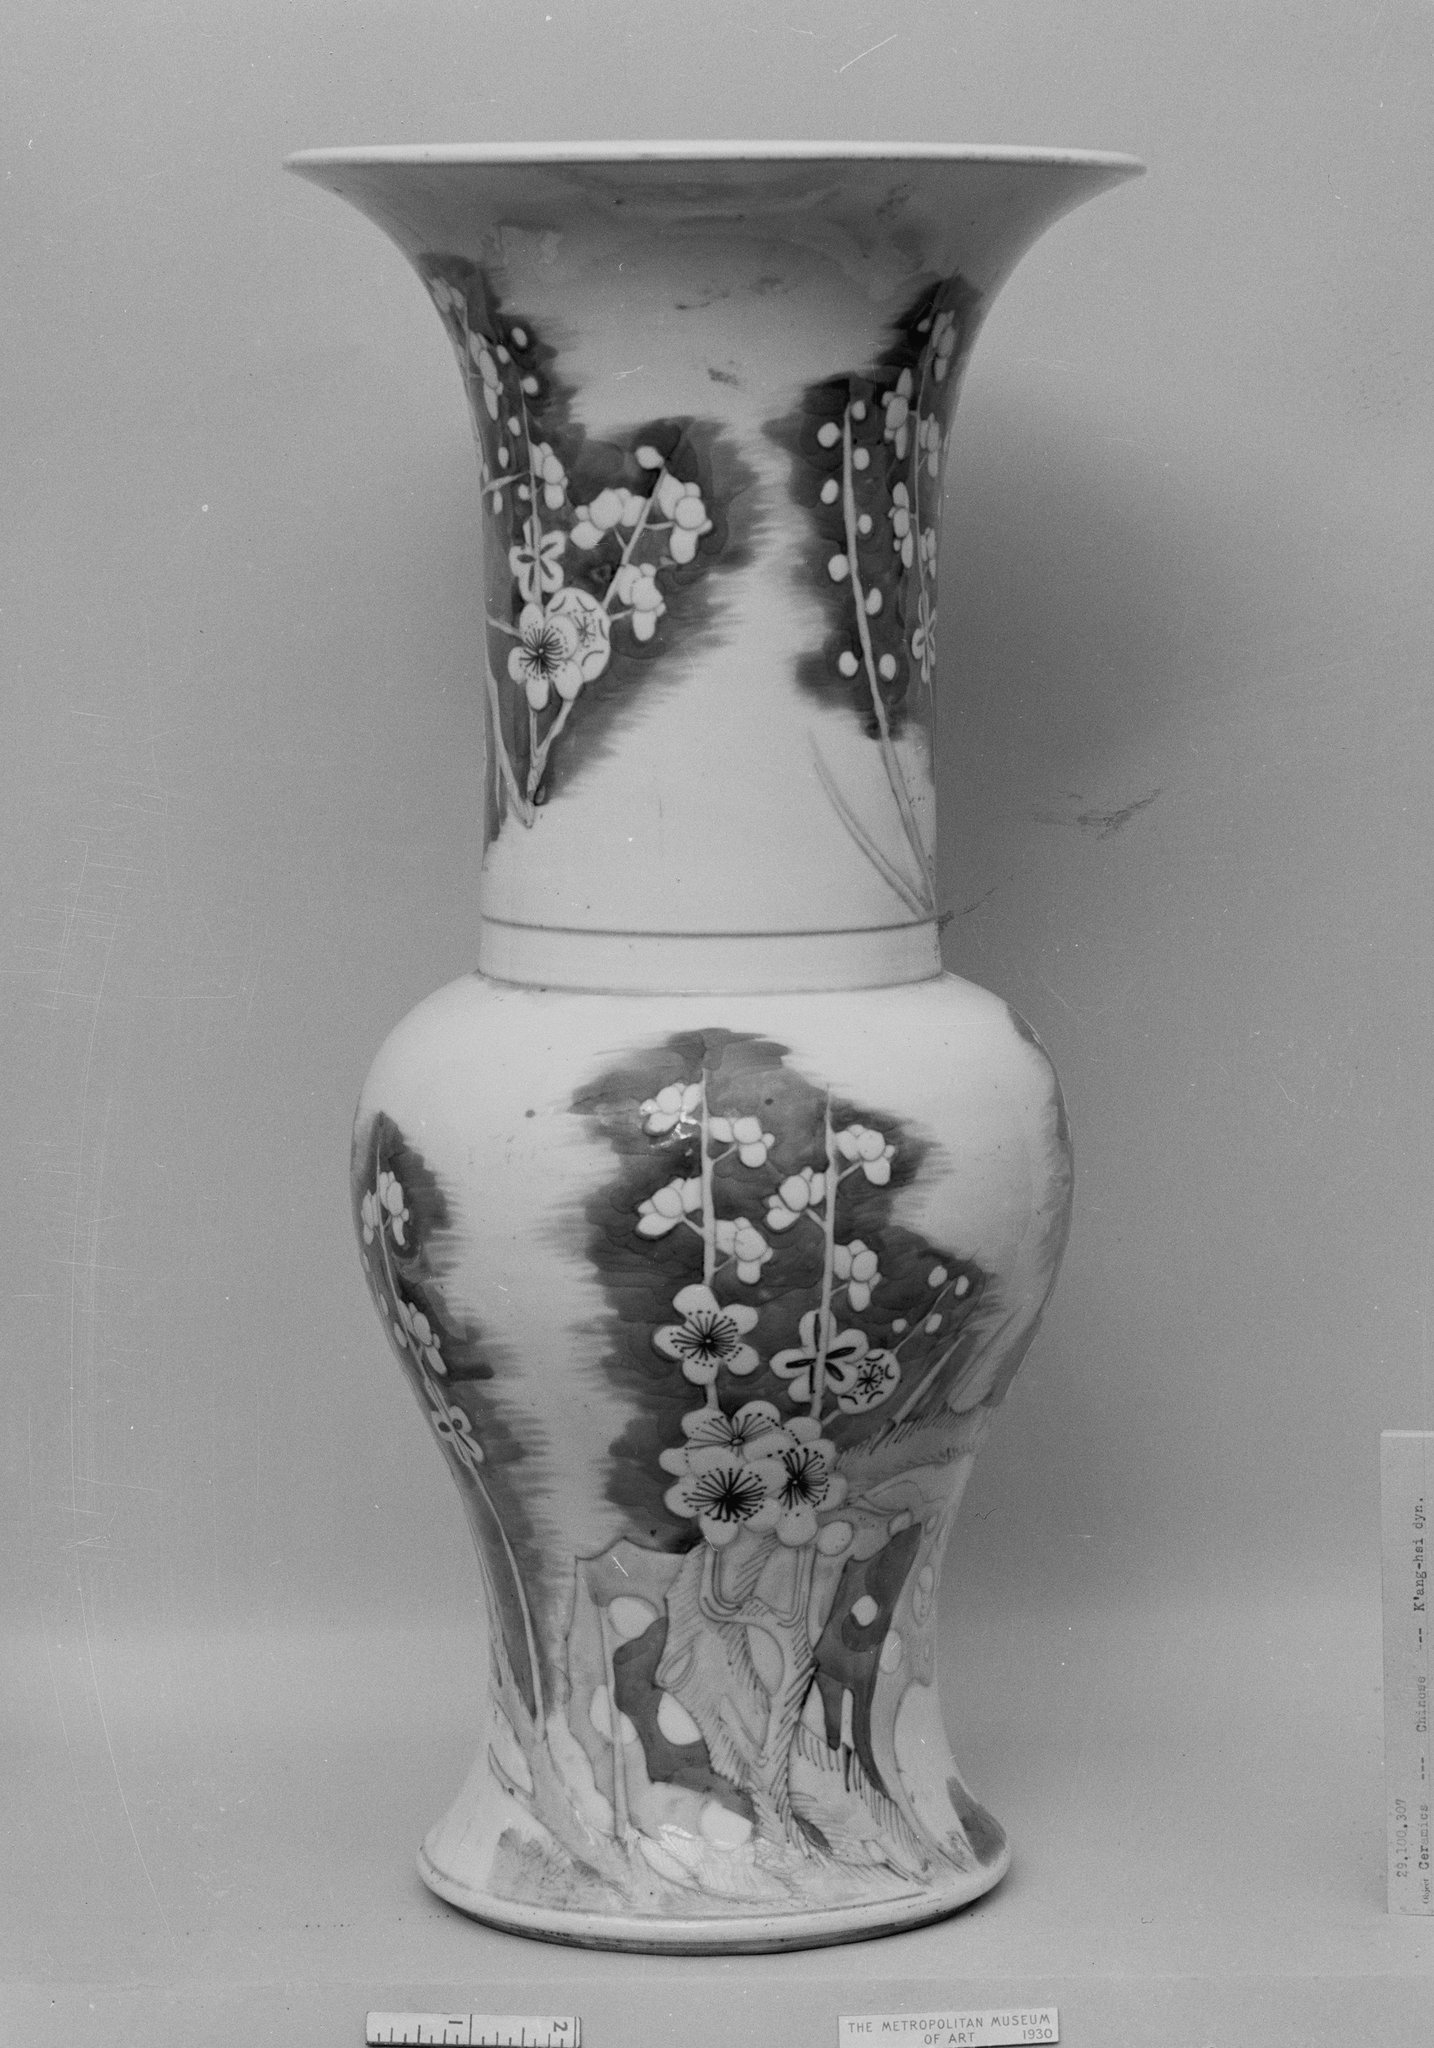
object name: vase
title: Vase decorated with blossoming plum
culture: chinese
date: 1662-1722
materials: cobalt, copper, glaze, porcelain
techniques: painting